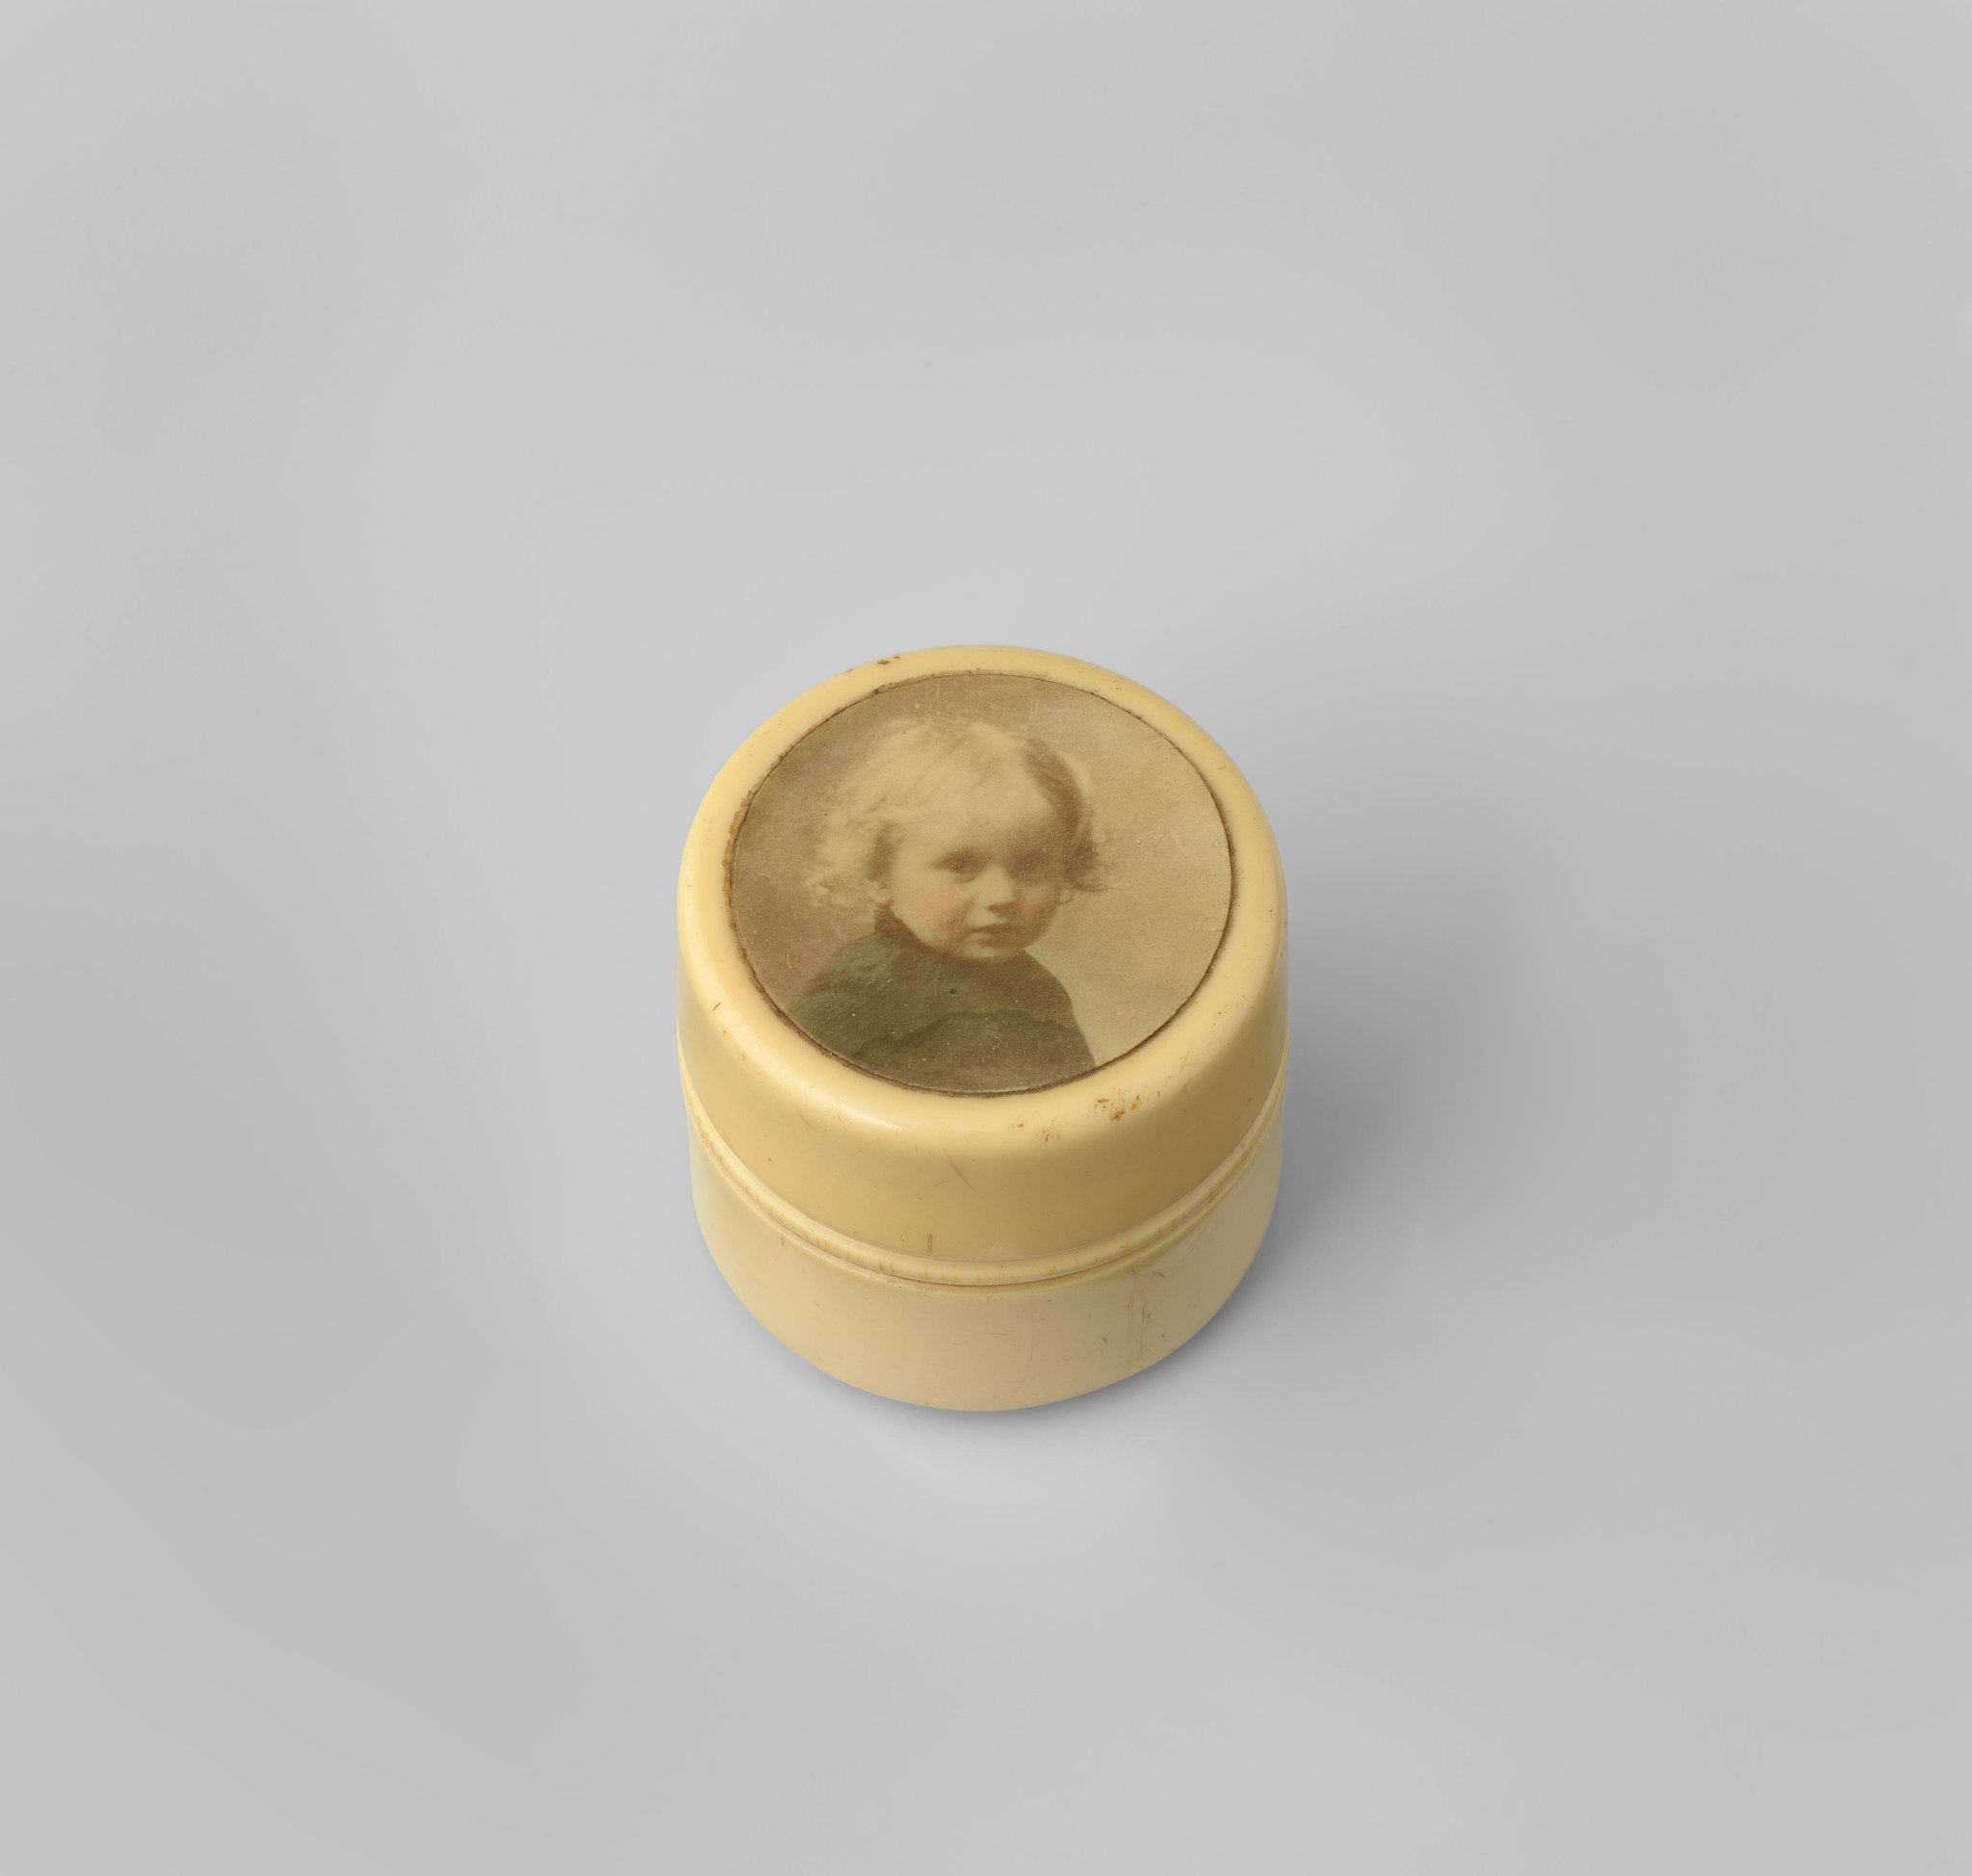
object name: photograph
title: Portret van een onbekend meisje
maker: Anonymous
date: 1900-1930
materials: celluloid, paper, plastic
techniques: albumen print, hand coloring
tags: girl (child between toddler and youth), anonymous historical person portrayed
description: Ronde plastic pillendoos met op het deksel een portretfoto van een klein meisje.